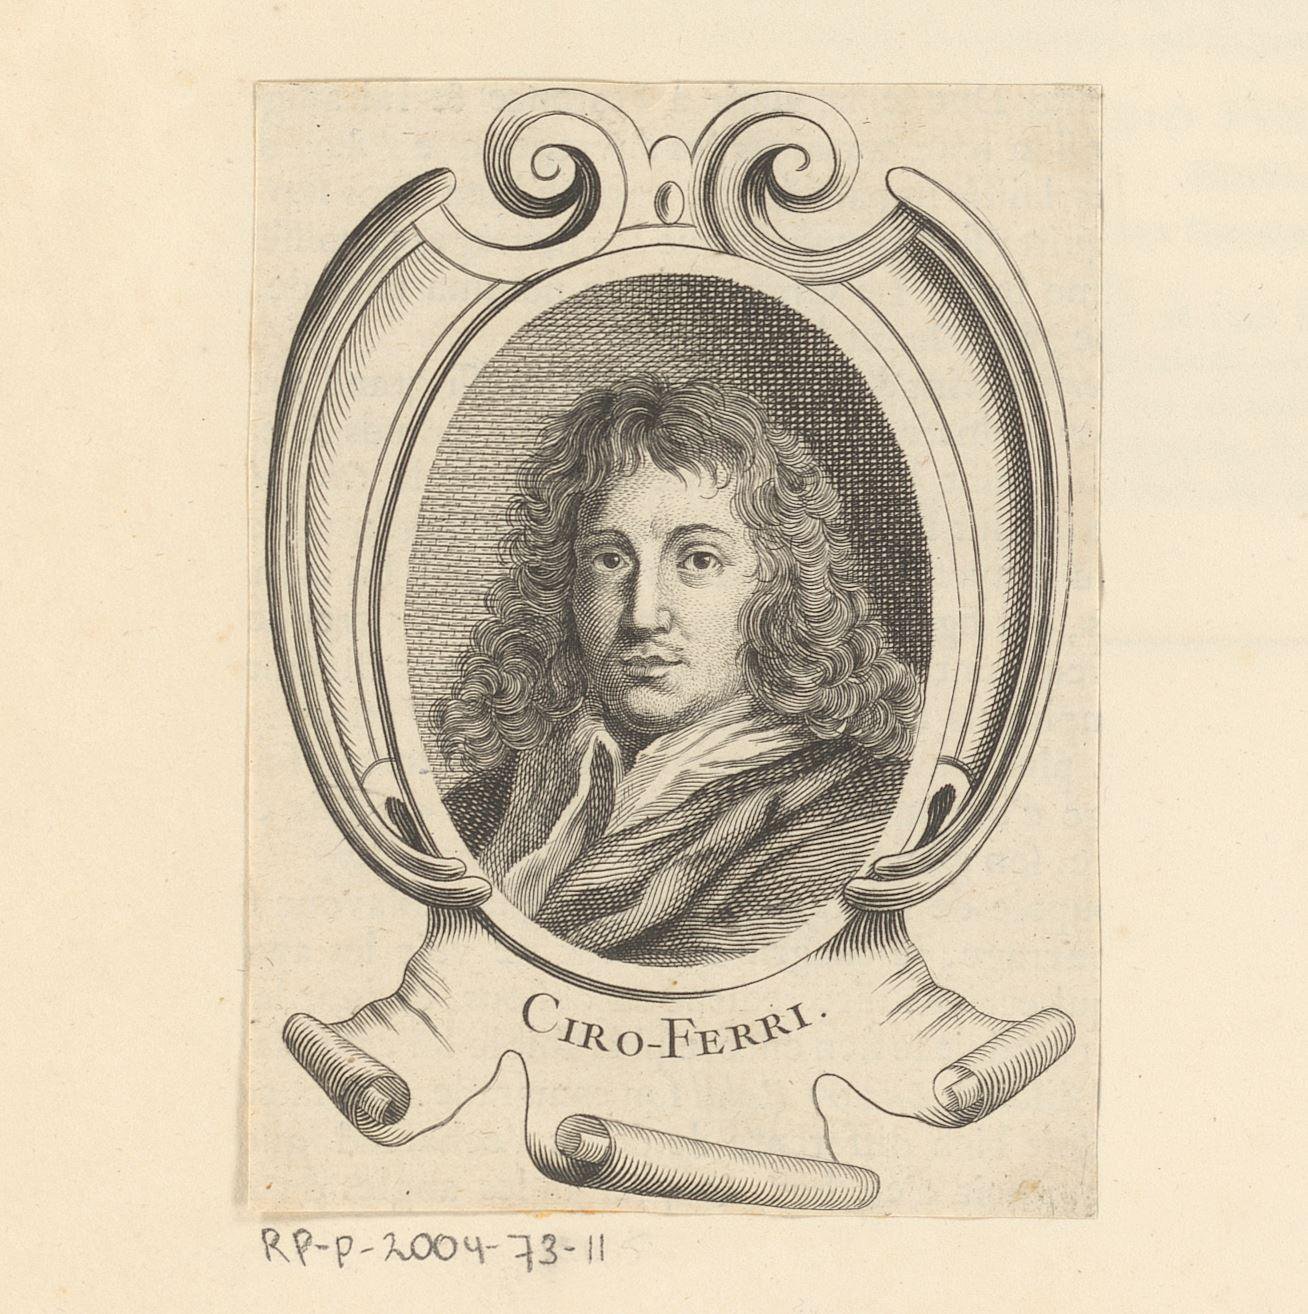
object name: print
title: Portret van Ciro Ferri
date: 1745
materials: paper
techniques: engraving, letterpress printing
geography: paris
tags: rome, ciro ferri, historical persons, portrait, self-portrait of painter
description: Prent uit: Dézallier d'Argenville, Antoine Joseph. Abrégé de la vie des plus fameux peintres. 4 dln. Parijs: De Bure l'aîné, 1745, dl. 1, p. 53. De samensteller heeft deze prent in het album geplakt als illustratie bij: Pilkington, Matthew en Johann Heinrich Füssli. A dictionary of painters, from the revival of the art to the present period. 4 dln. Londen: John Crowder, 1805, dl. 2, p. 185.